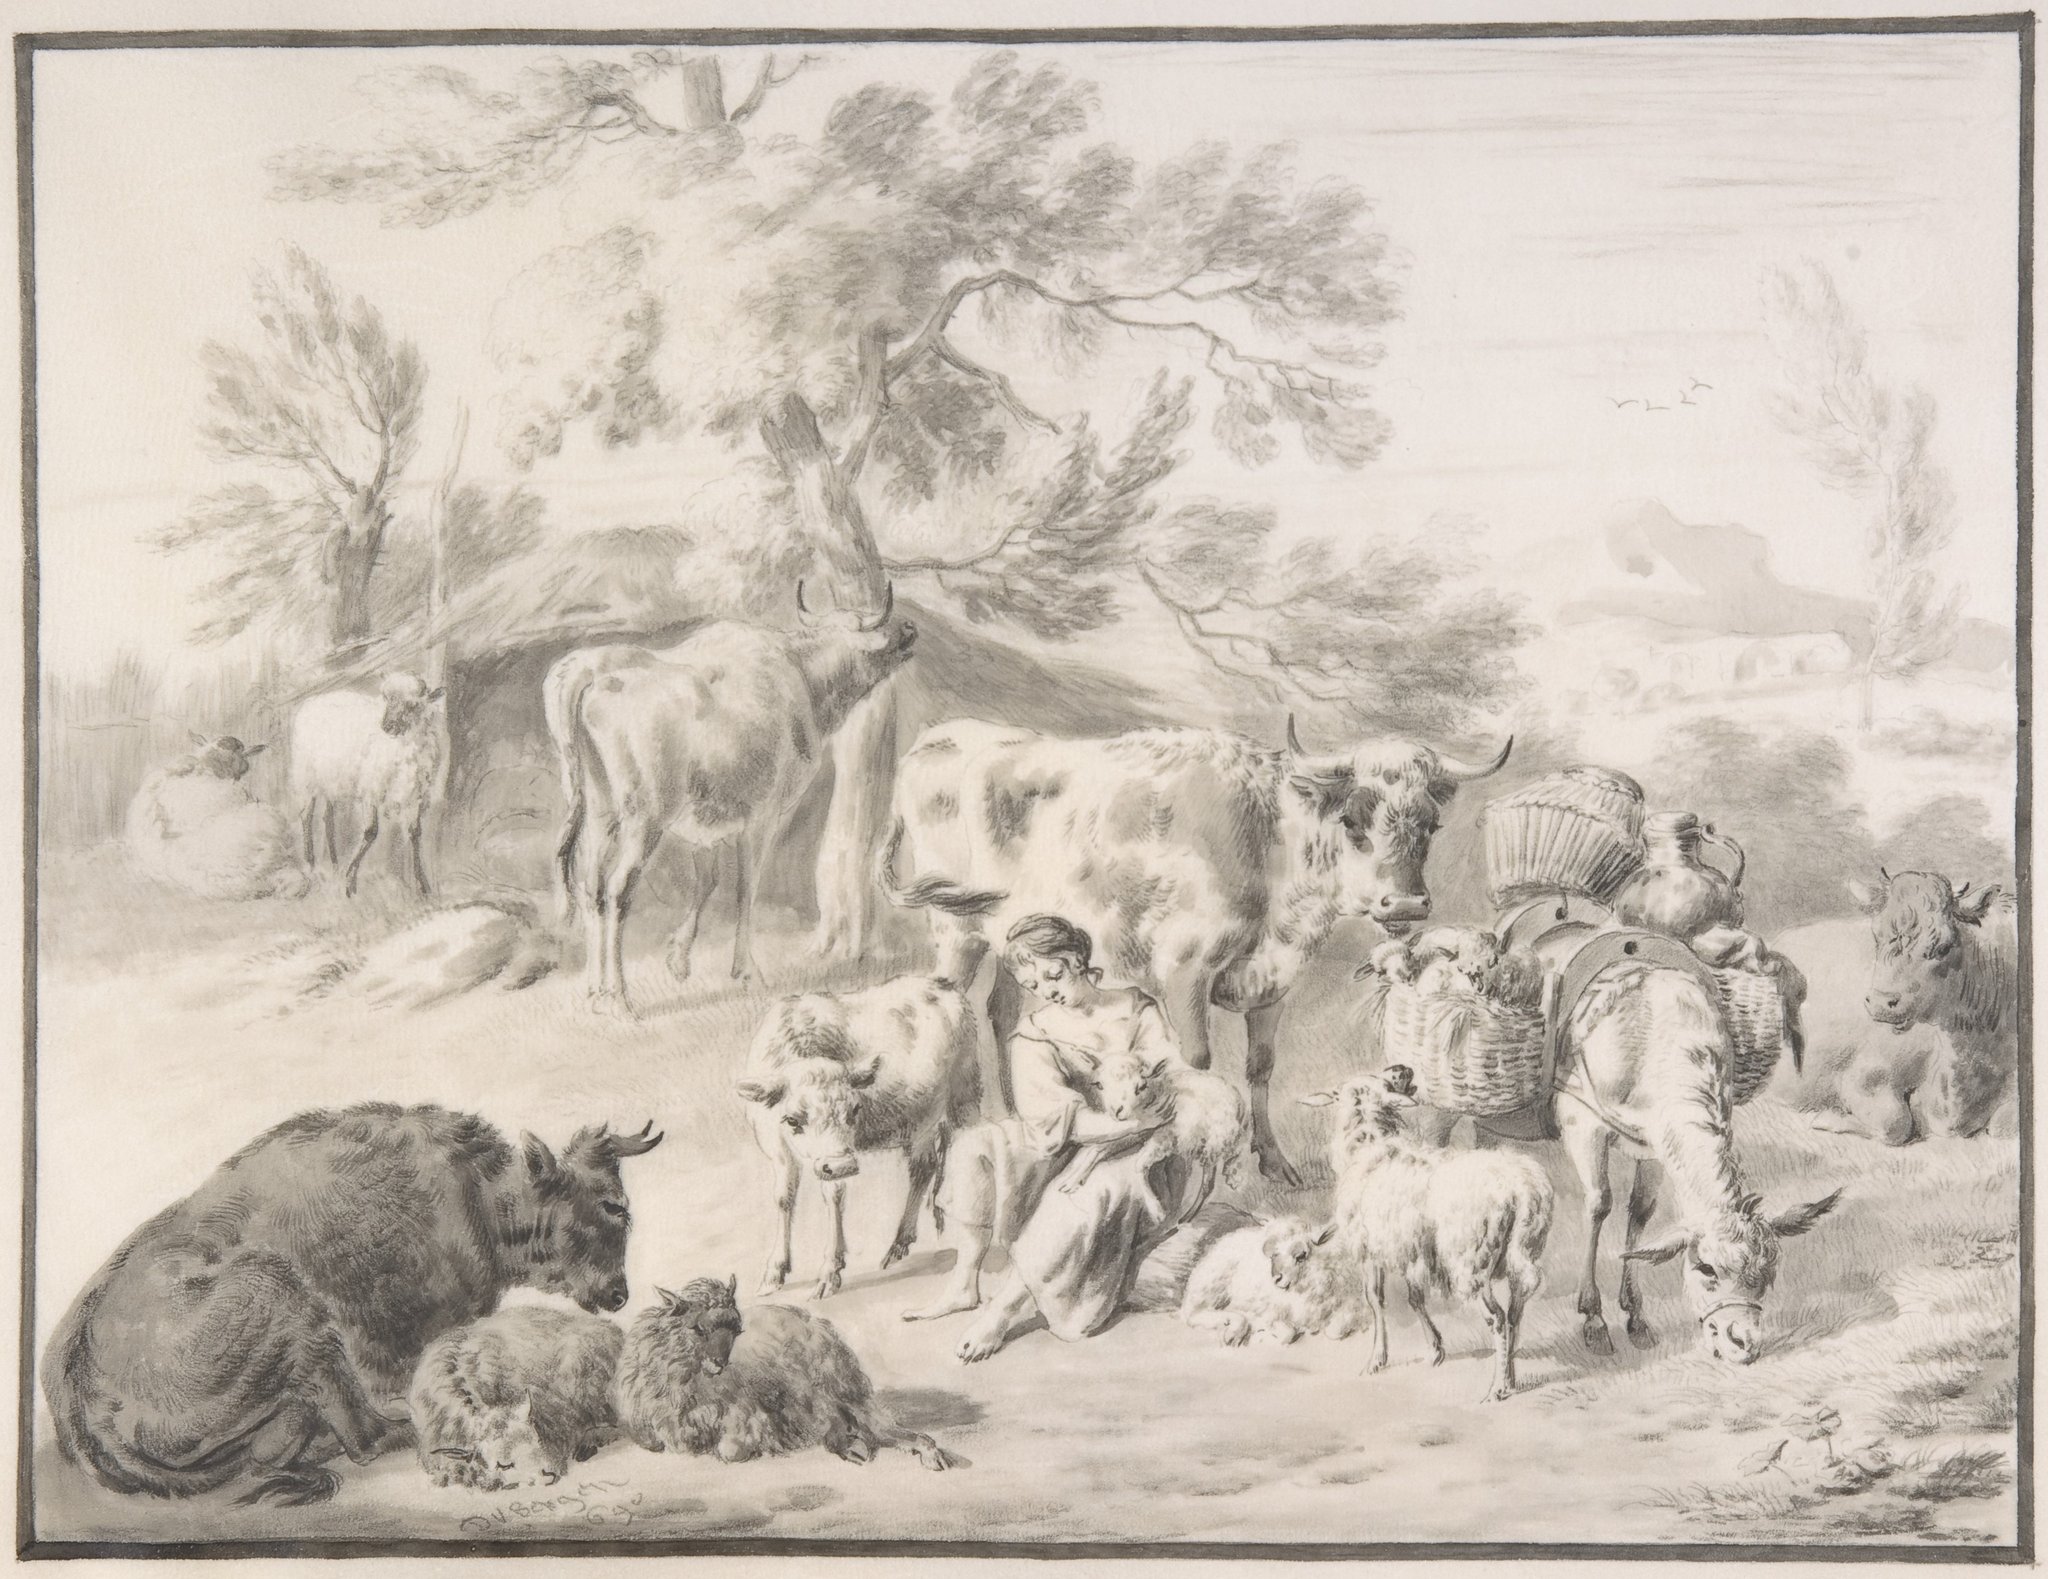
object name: drawing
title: A Herdswoman Seated Amongst Her Animals, with a Lamb in Her Arms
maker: dirck van bergen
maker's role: artist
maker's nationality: dutch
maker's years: 1645-1690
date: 1690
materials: chalk, ink, parchment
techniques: brush, pen, wash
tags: women,cows,lambs,trees